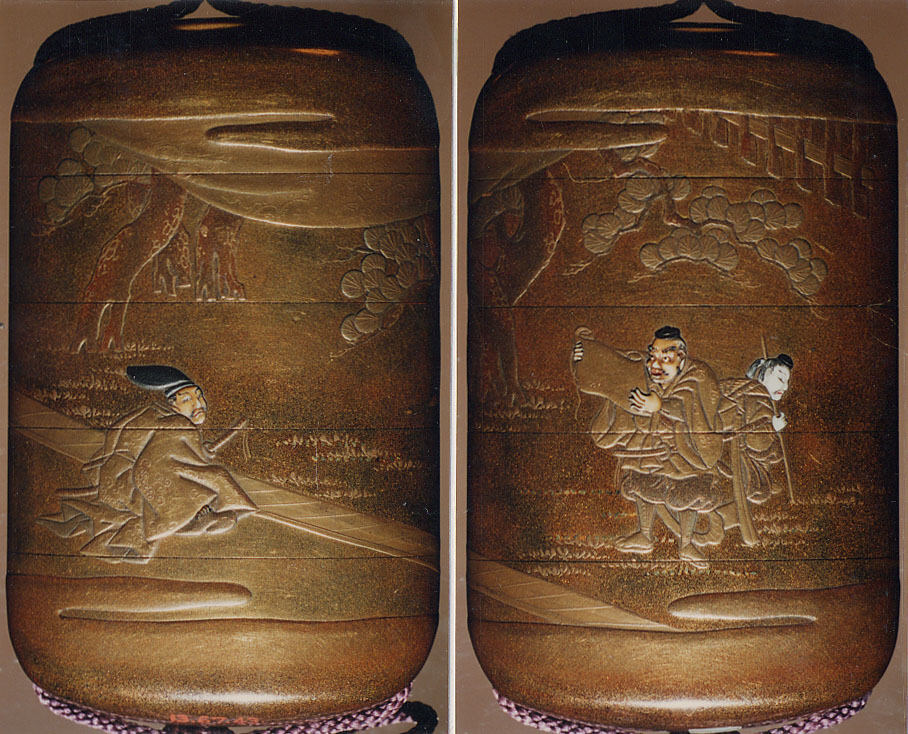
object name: inrō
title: Case (Inrō) with Benkei and Yoshitsune Disguised on the Flight to Ōshū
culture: japanese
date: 1801-1900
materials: gold, ivory, lacquer, silver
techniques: fundame, hiramakie, inlay, stain, maki-e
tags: men,reading,trees